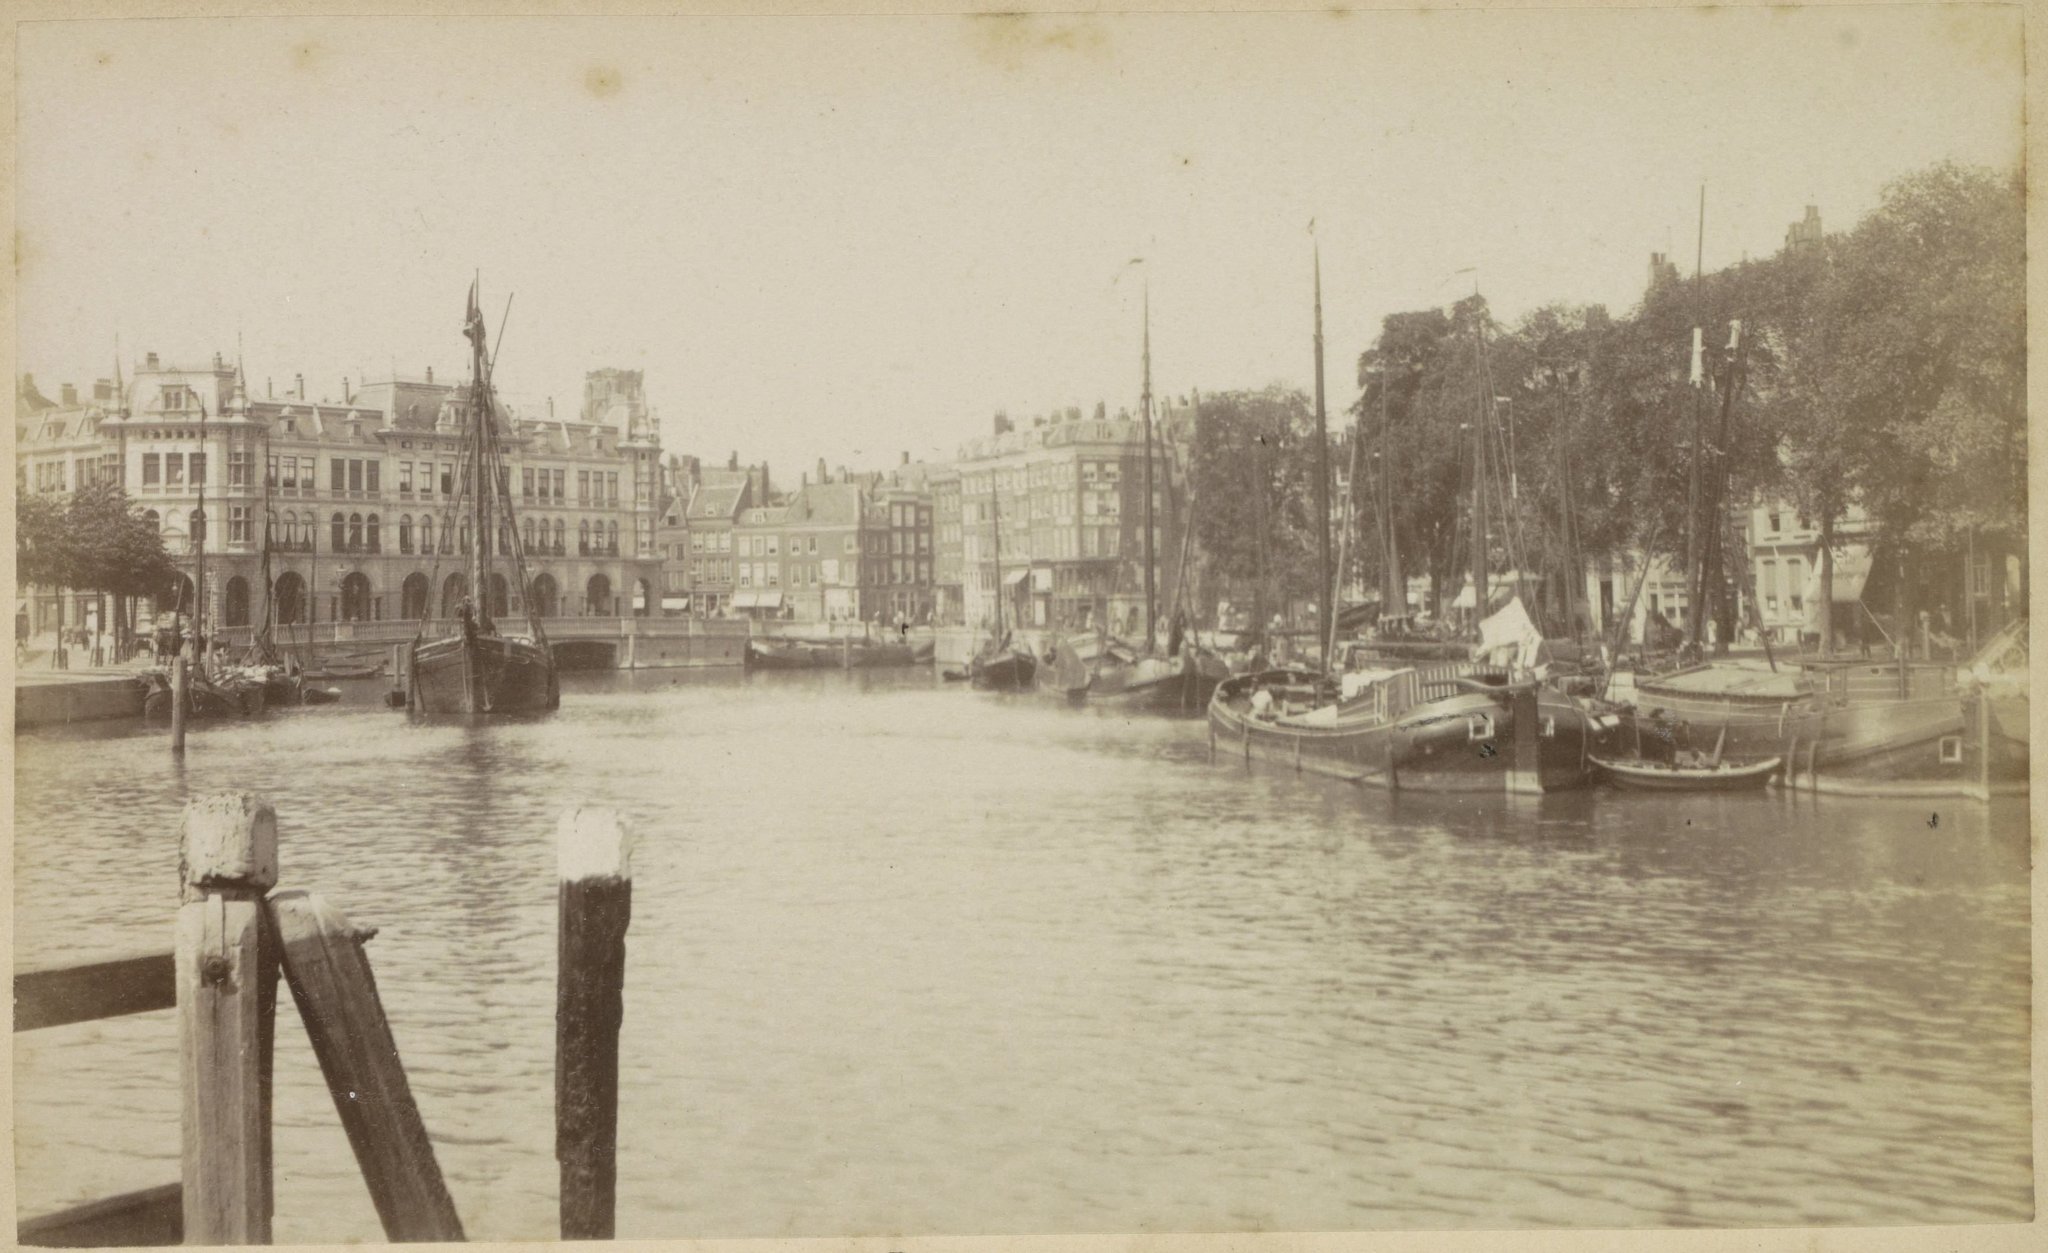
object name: cabinet photograph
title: De Spaansche Kade. Rotterdam.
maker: andries jager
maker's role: publisher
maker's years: 1825-1905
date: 1860-1900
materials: cardboard, photographic support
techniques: albumen print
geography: rotterdam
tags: quay (+ city(-scape) with figures, staffage), steamship, motorship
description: Onderdeel van Leporelloalbum met foto's van Rotterdam.